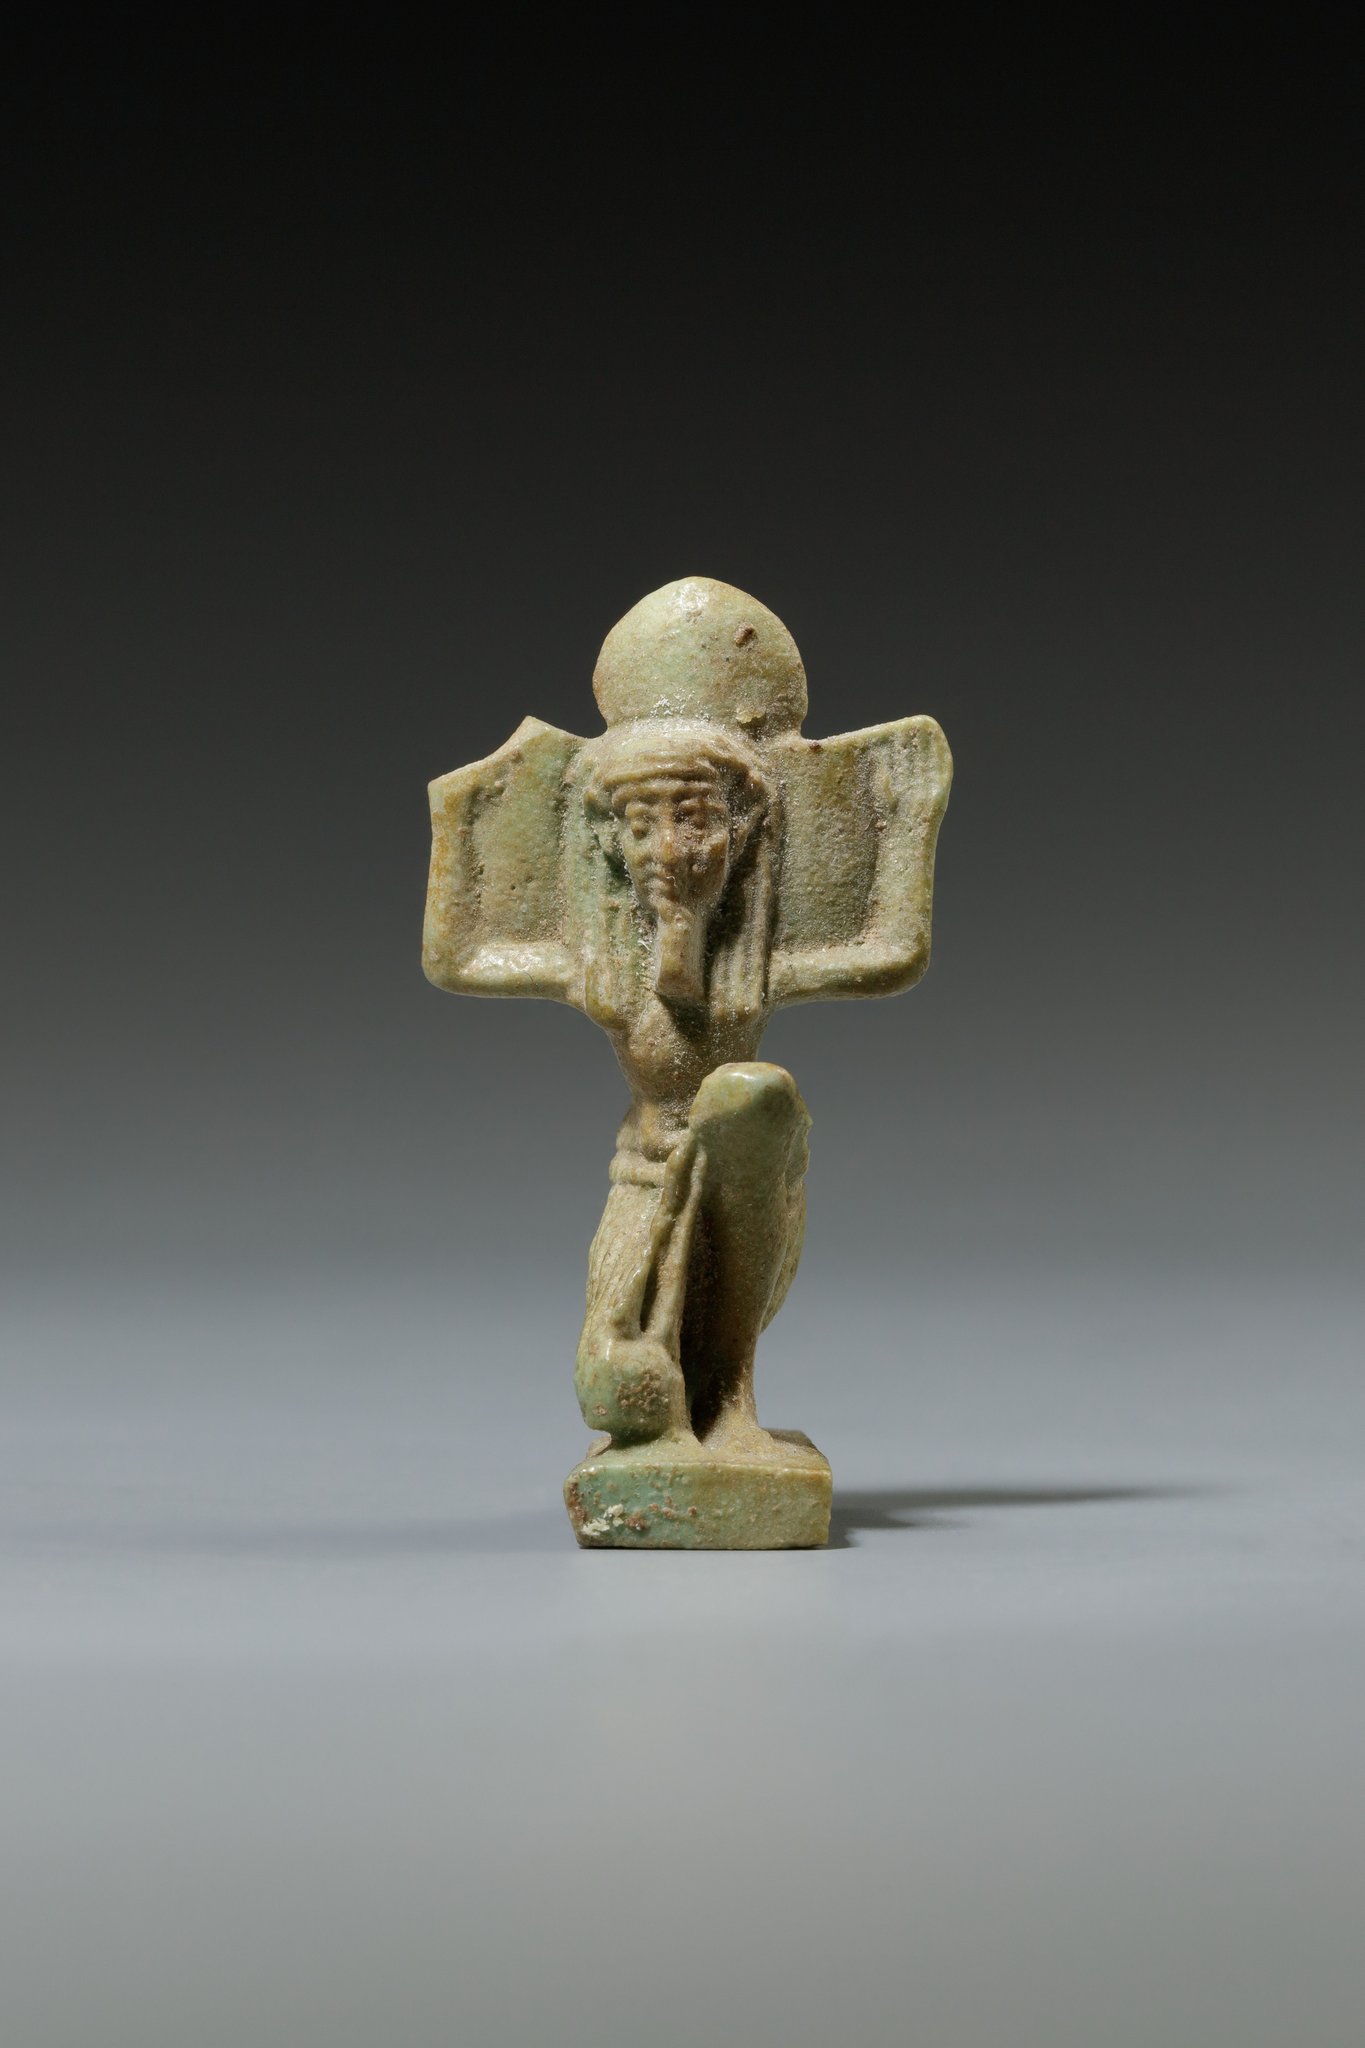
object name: amulet, shu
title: Shu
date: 664-630 BCE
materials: faience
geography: egypt